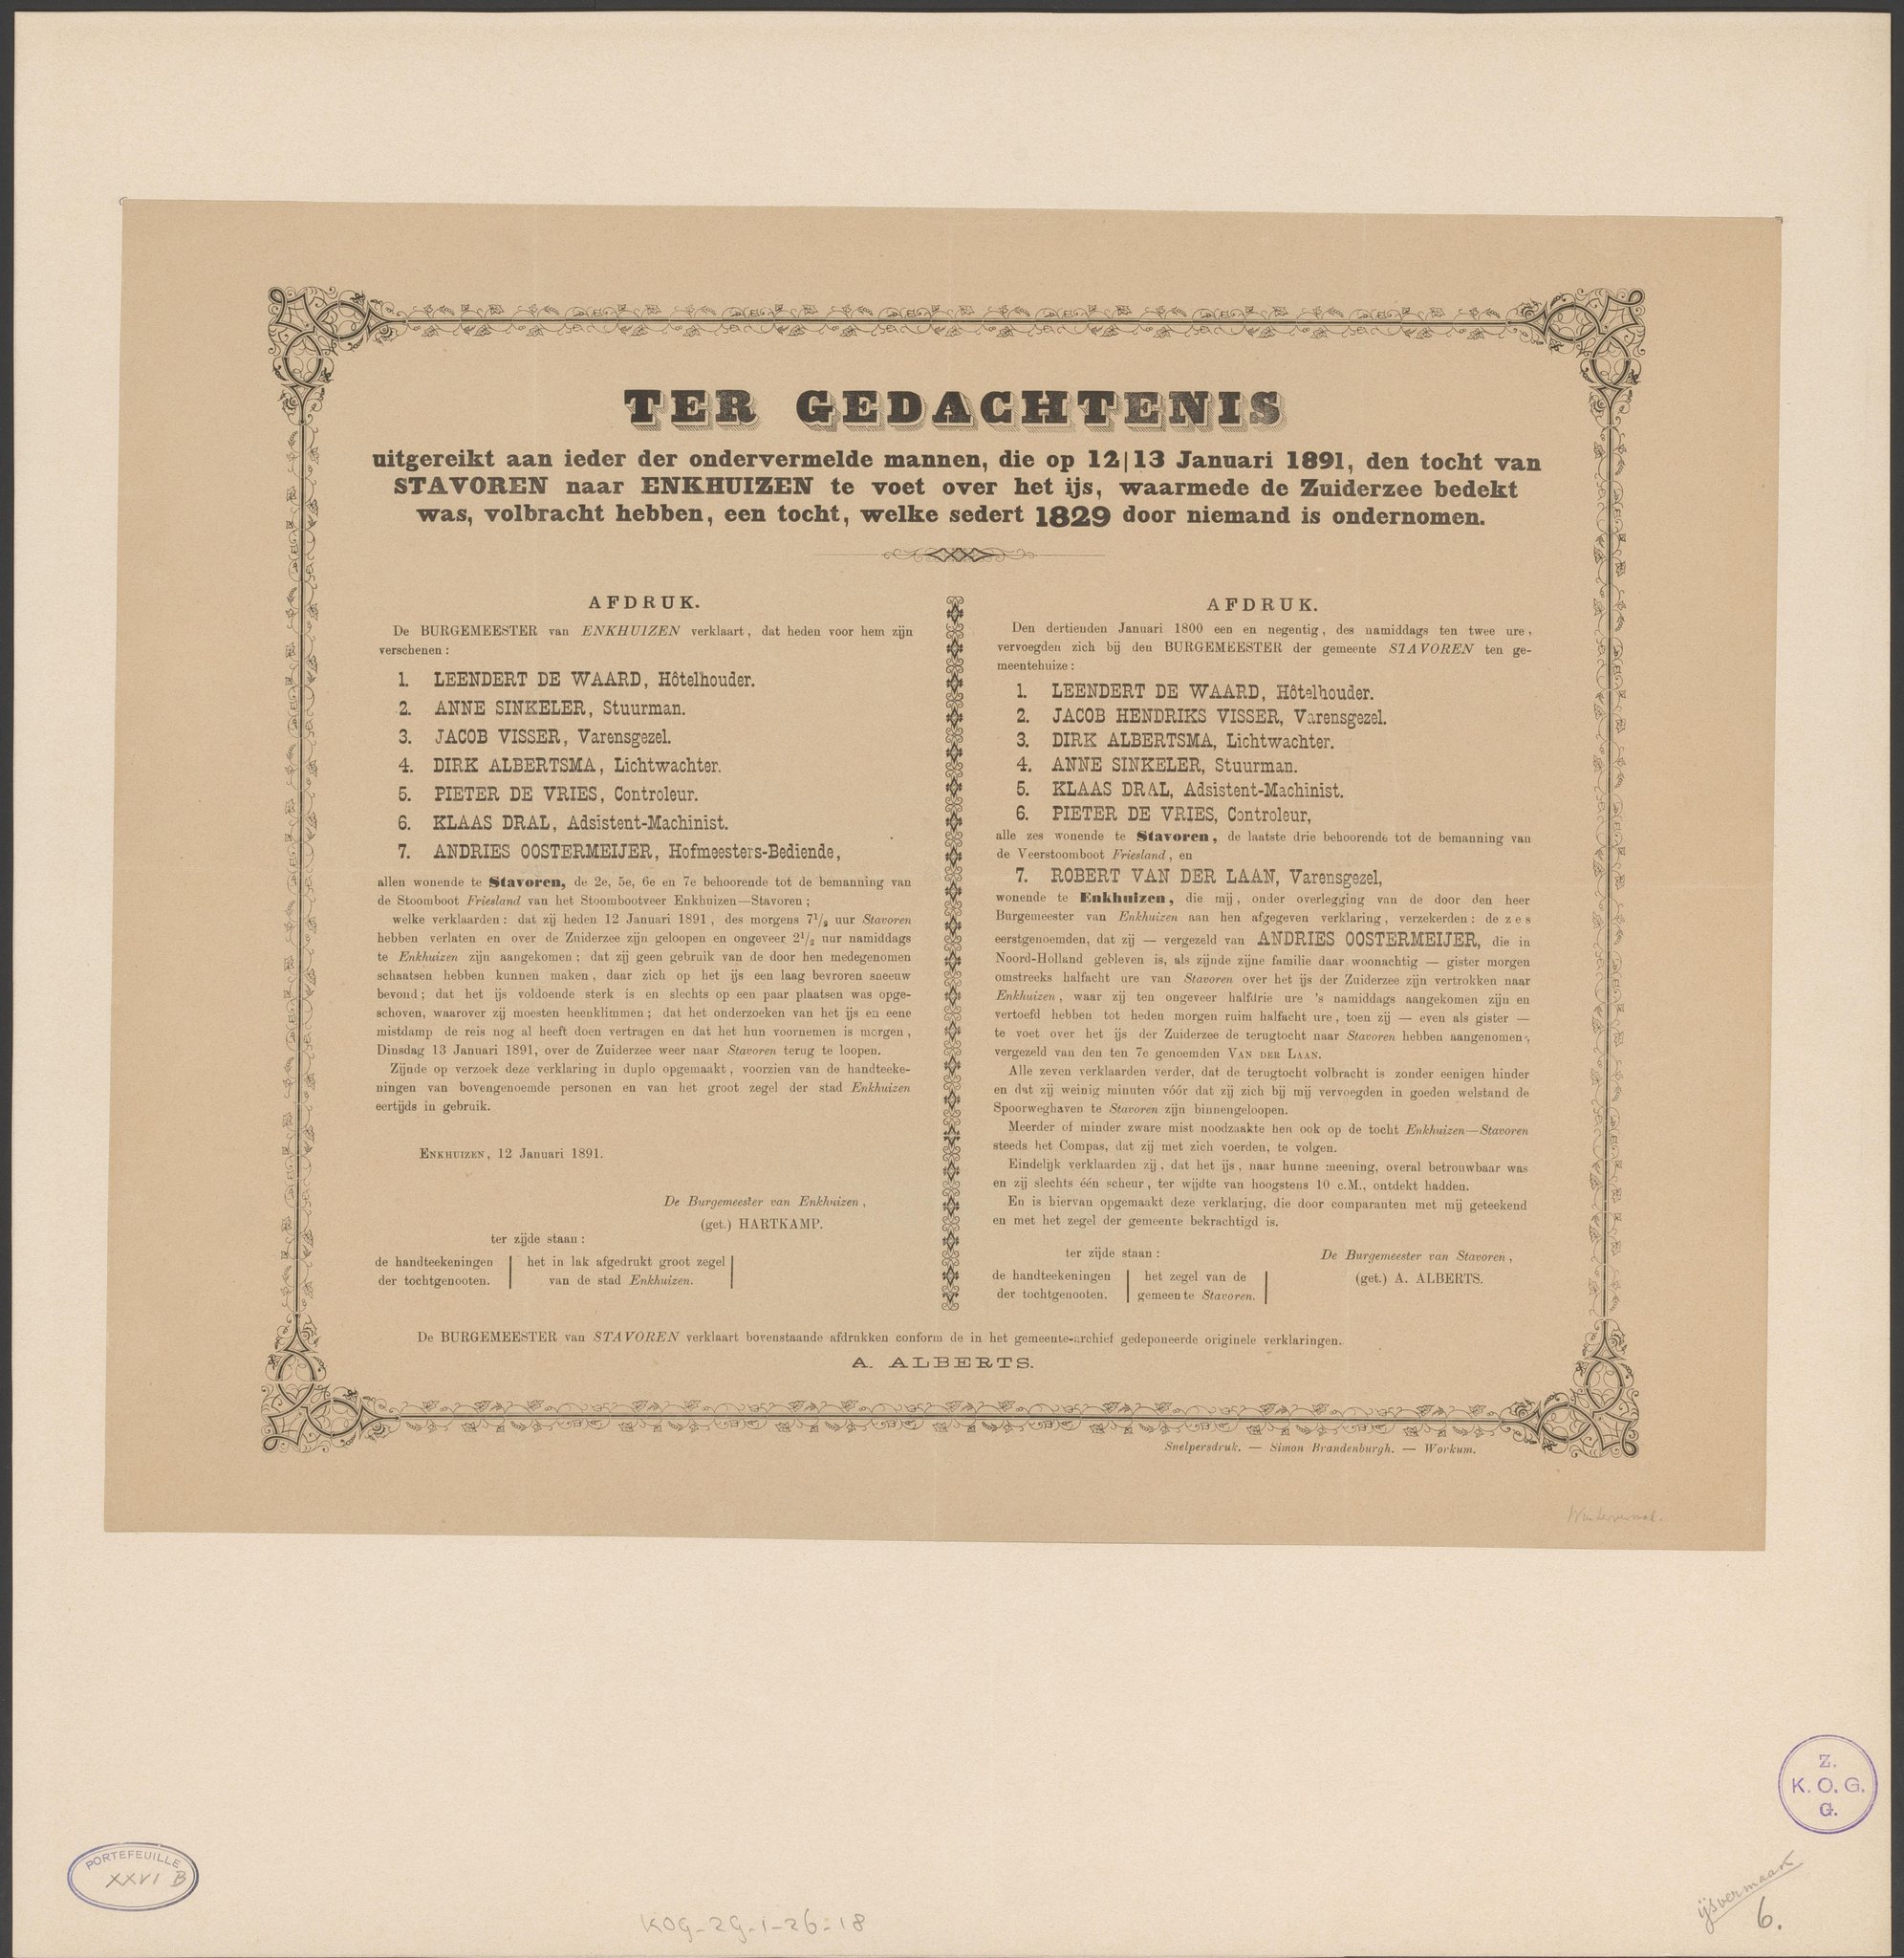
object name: text sheet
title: Ter Gedachtenis / uitgereikt aan ieder der ondervermelde mannen, die op 12/13 januari 1891, den tocht van Stavoren naar Enkhuizen te voet over het ijs, waarmede de Zuiderzee bedekt was, volbracht hebben, een tocht, welke sedert 1829 door niemand is ondernomen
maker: simon brandenburgh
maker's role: printer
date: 1891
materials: paper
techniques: letterpress printing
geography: workum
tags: ice ~ freezing weather, severe winters, enkhuizen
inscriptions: collector's mark: Lugt 1641, collector's mark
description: Verklaring over de voettocht van zeven mannen over het ijs de bevroren Zuiderzee van Stavoren naar Enkhuizen, 12-13 januari 1891. Opgesteld en ondertekend door de burgemeesters van beide plaatsen. Onderwerpsrubrieken binnen de Atlas Zeden en Gewoonten: Spel en Vermaak; IJsvermaak, Strenge winters.